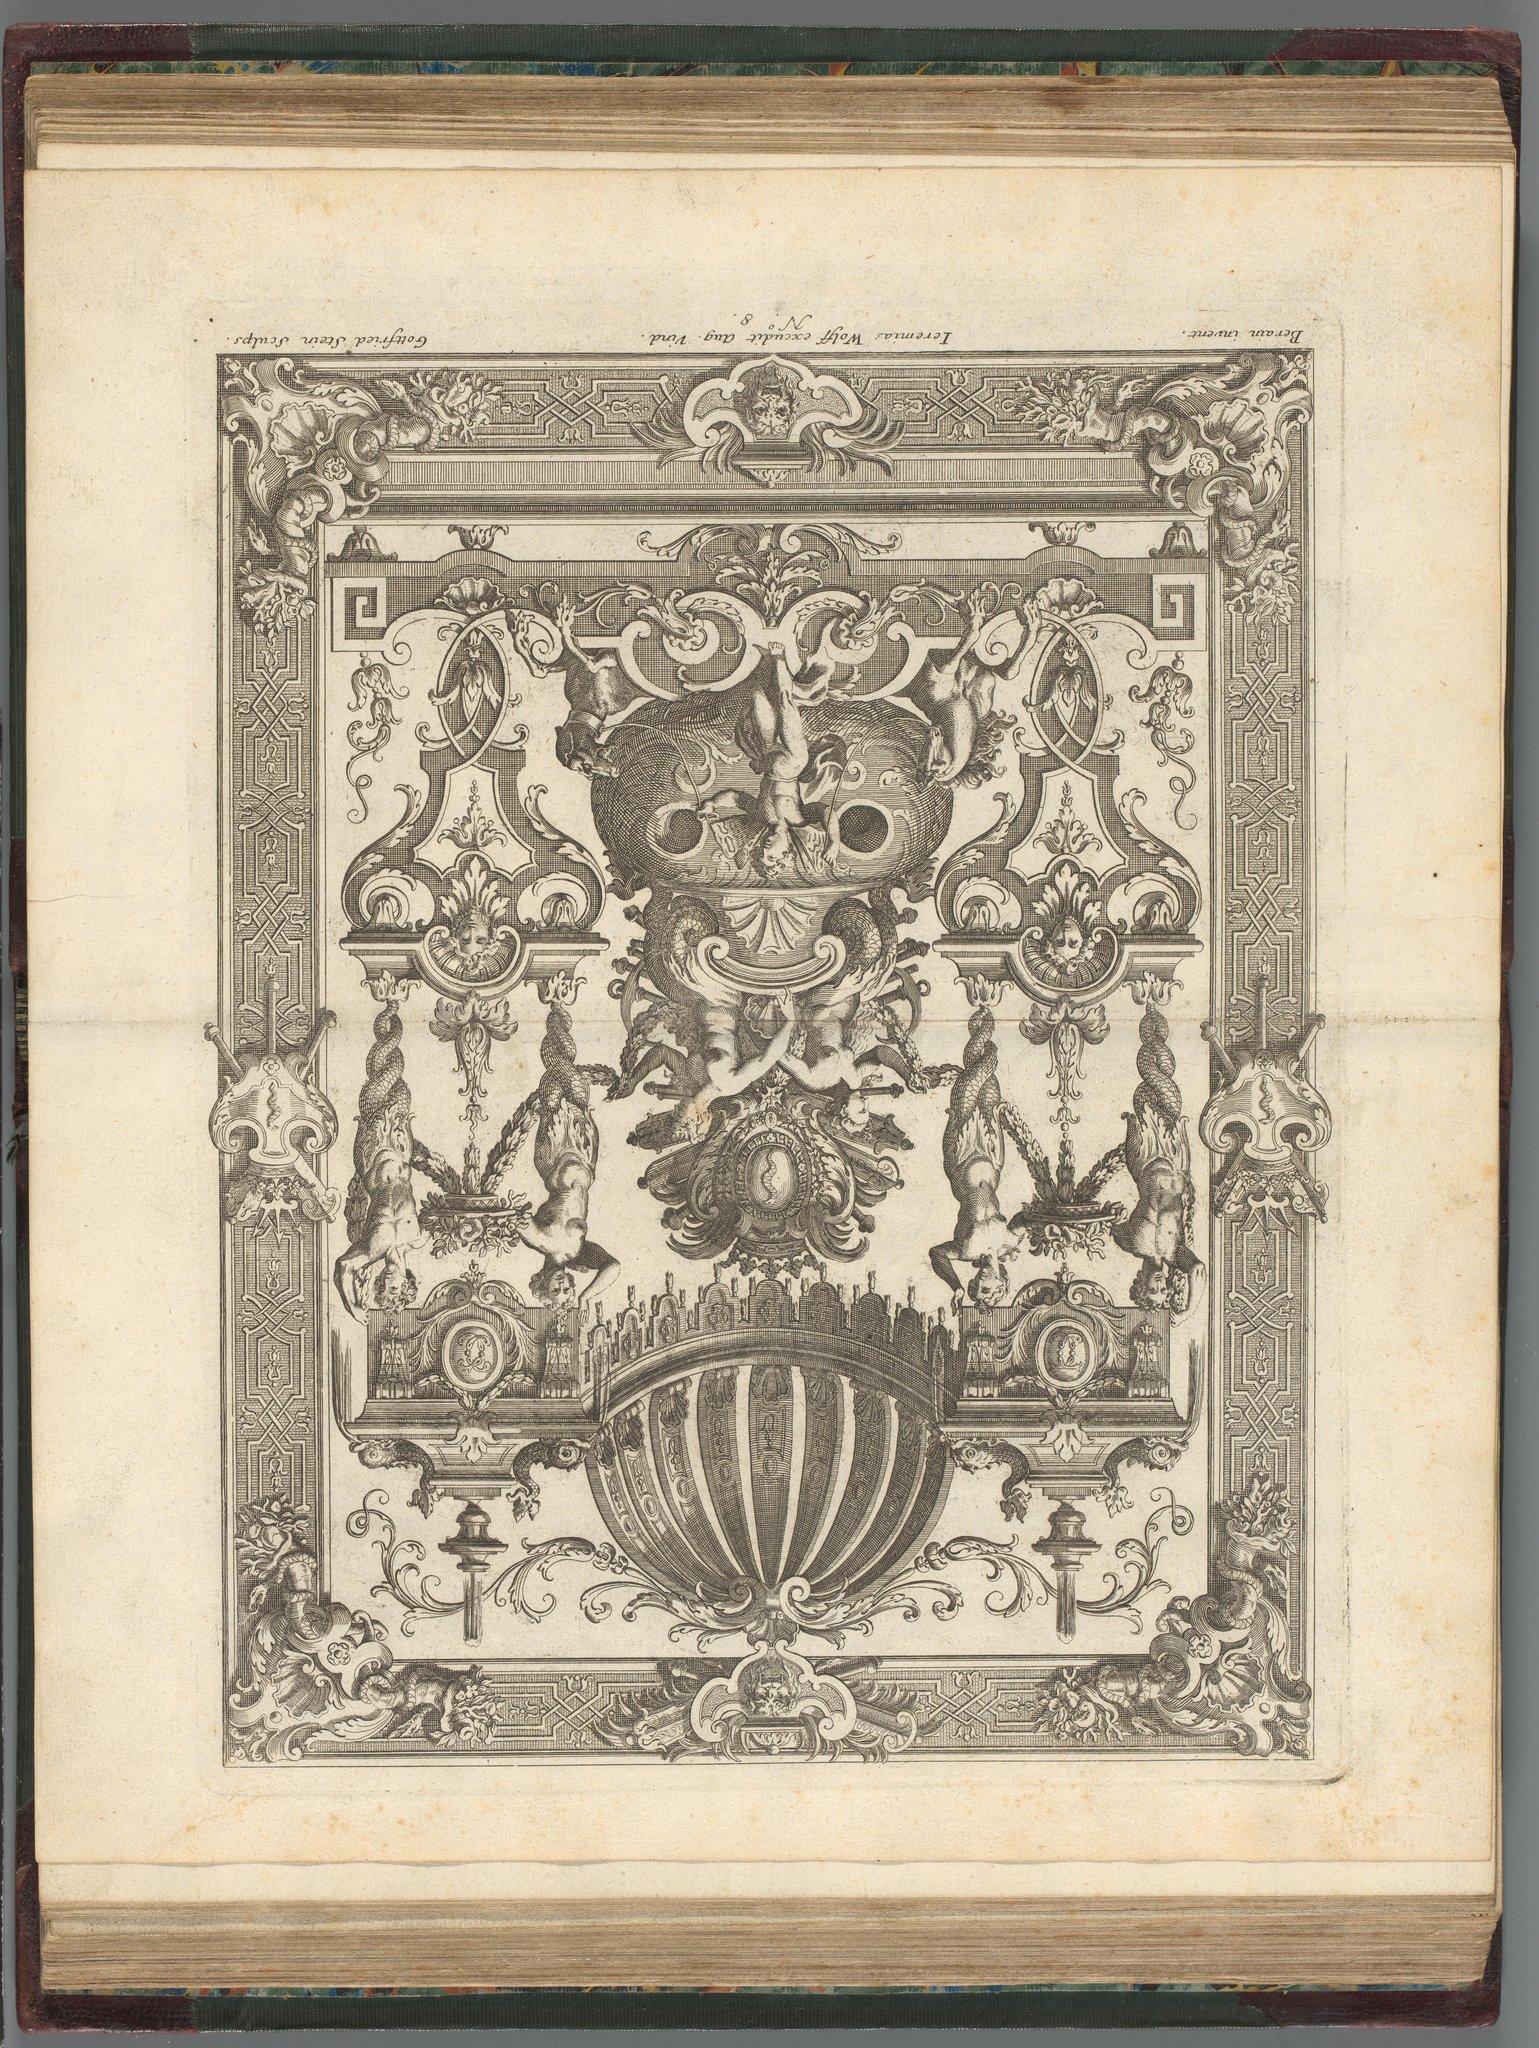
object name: ornament print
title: Compositie met tritons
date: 1697-1724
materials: paper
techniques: etching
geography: augsburg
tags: ornaments ~ art, triton(s), other architectural details (cupola)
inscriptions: signature: ‘Gottfried Stein Sculps.’, signature: ‘Ieremias Wolff excudit Aug. Vind.’, number: ‘No. 8.’, signature: ‘Berain invent.’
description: Een decoratieve compositie met tritons onder een halve koepel met daaronder een paard en een hond vastgehouden door een putto. Prent maakt deel uit van een album. Hoogstwaarschijnlijk gespiegelde kopie naar Frans origineel.